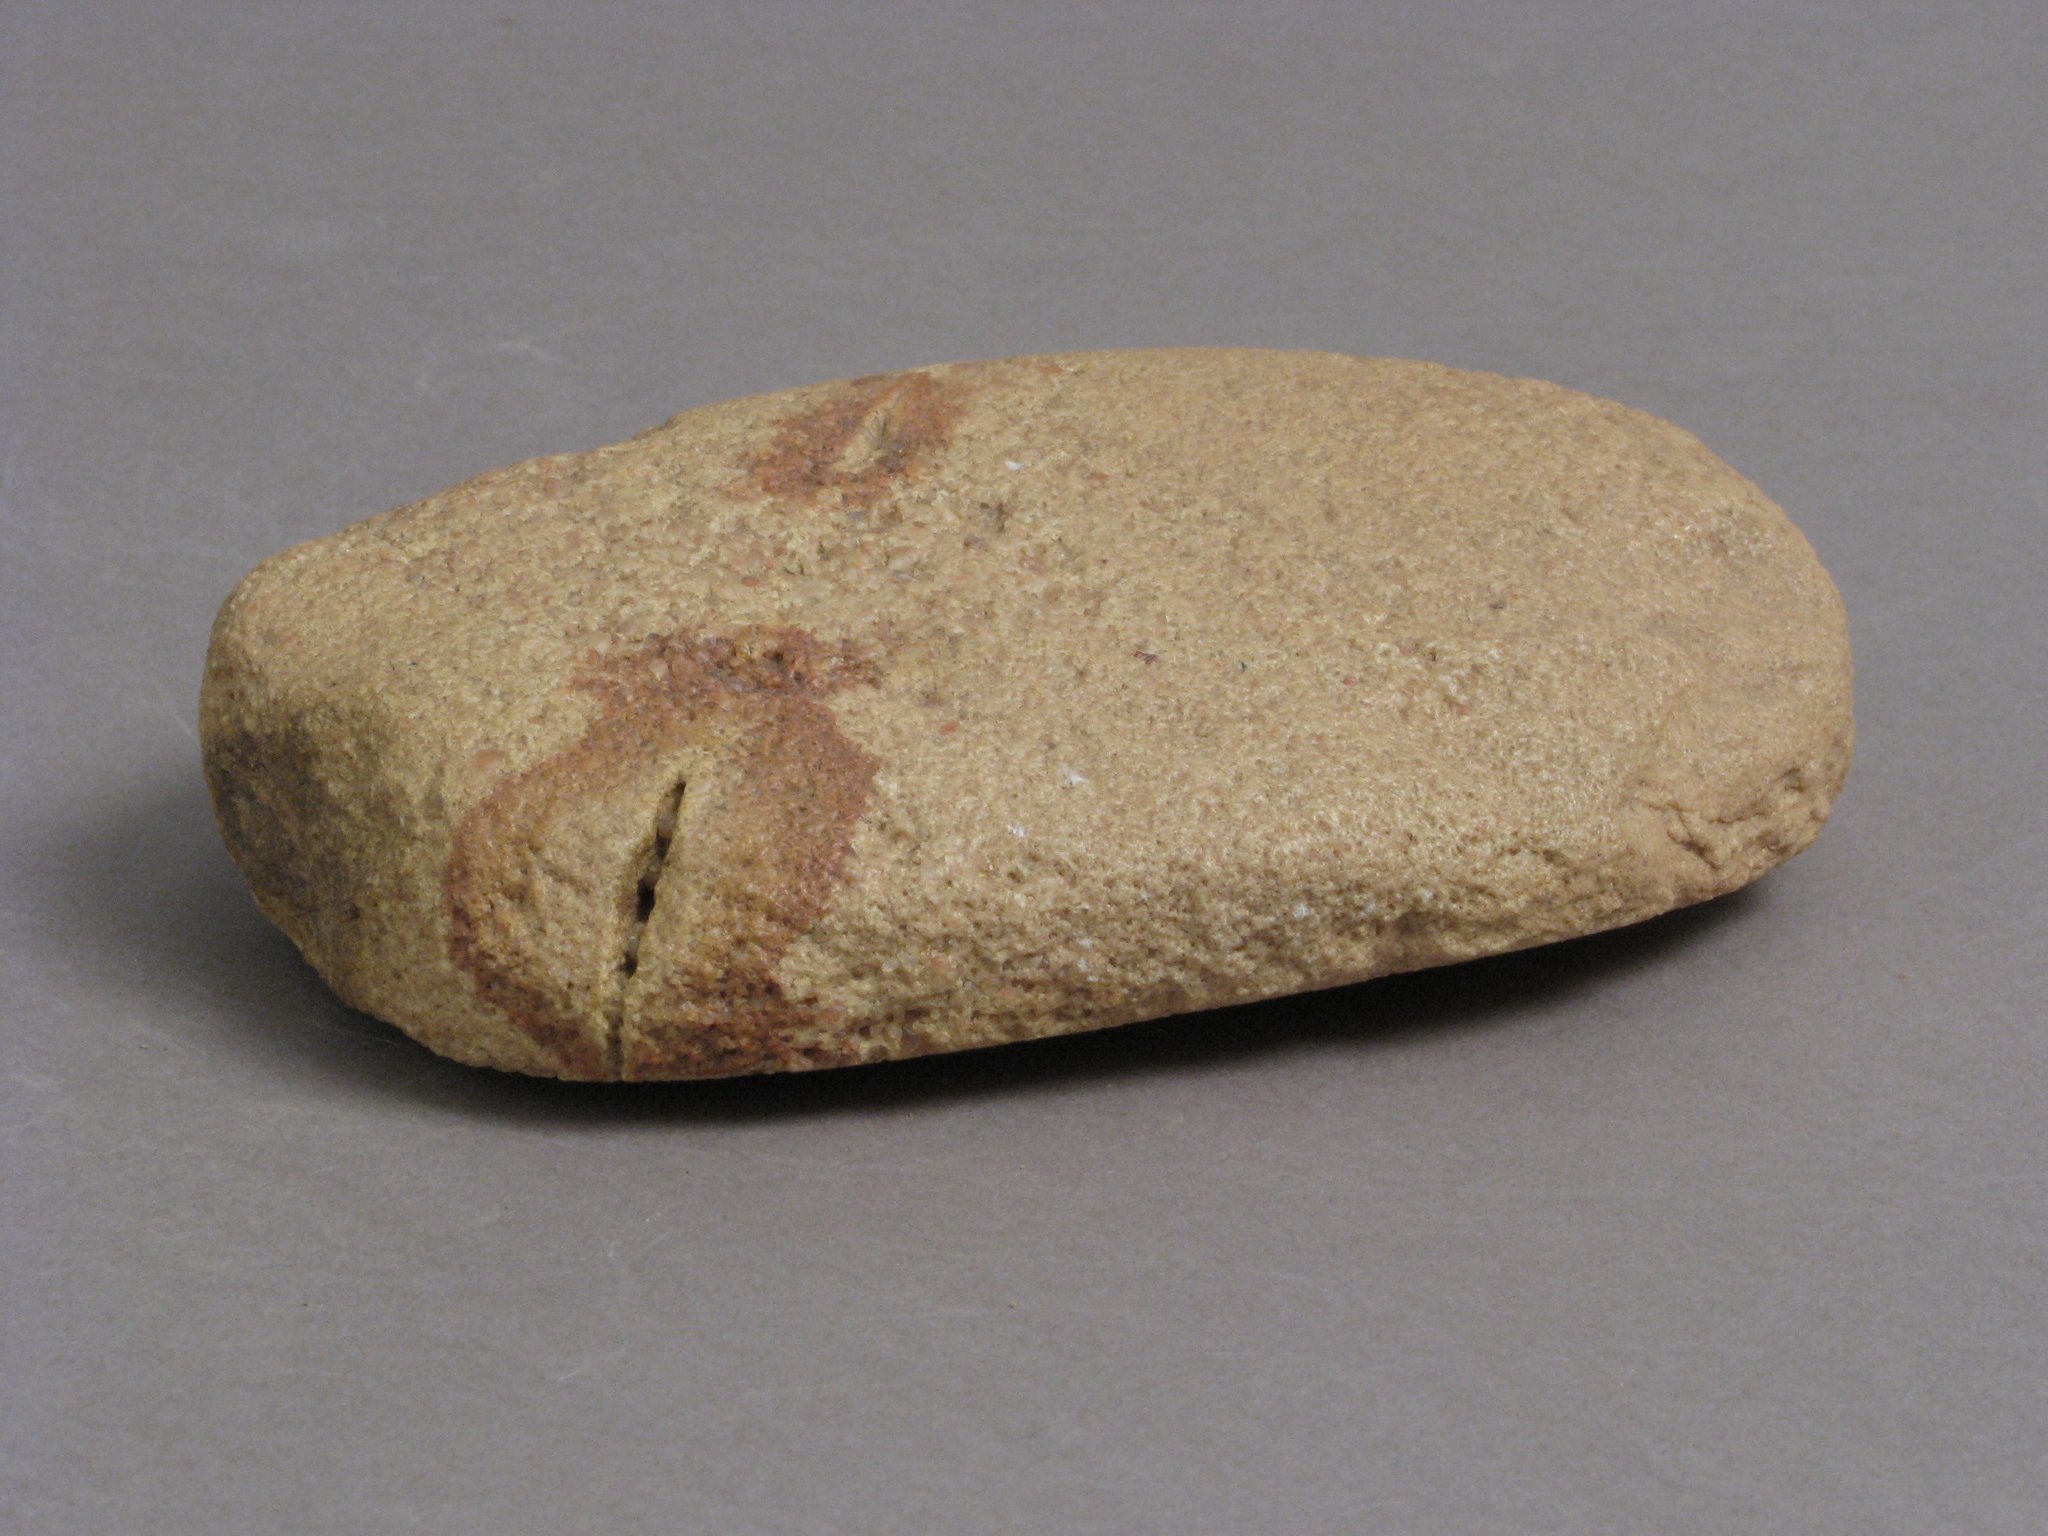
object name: stone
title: Grinding Stone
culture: coptic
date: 301-700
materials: stone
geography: egypt